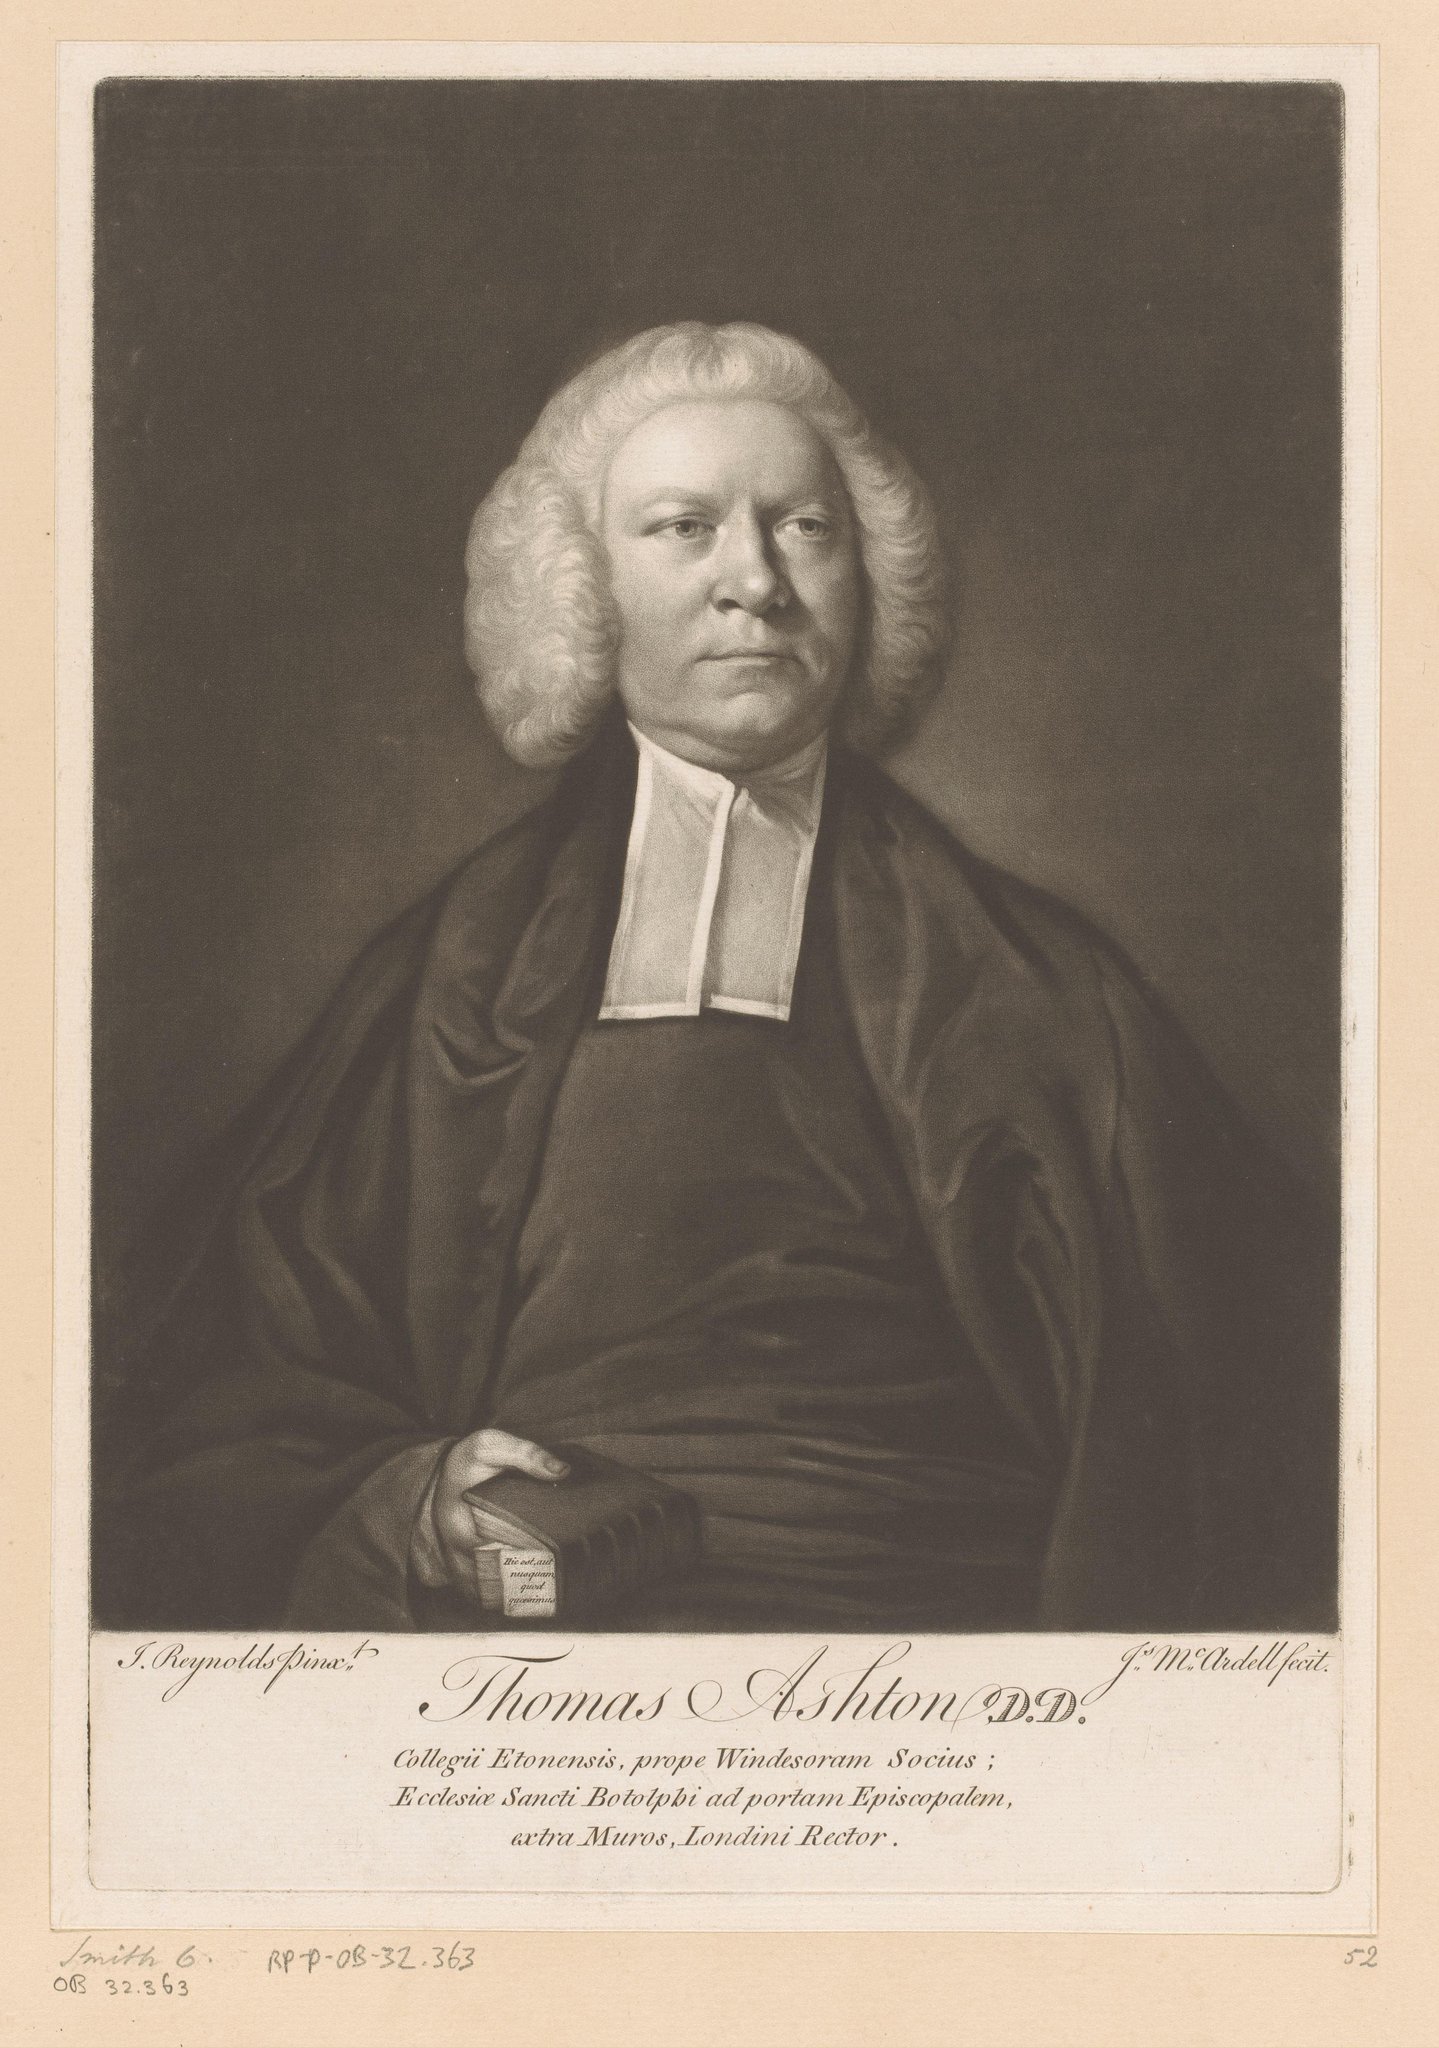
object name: print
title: Portret van Thomas Ashton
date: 1763-1765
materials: paper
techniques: mezzotint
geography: london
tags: clergyman, historical persons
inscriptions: collector's mark: Lugt 240